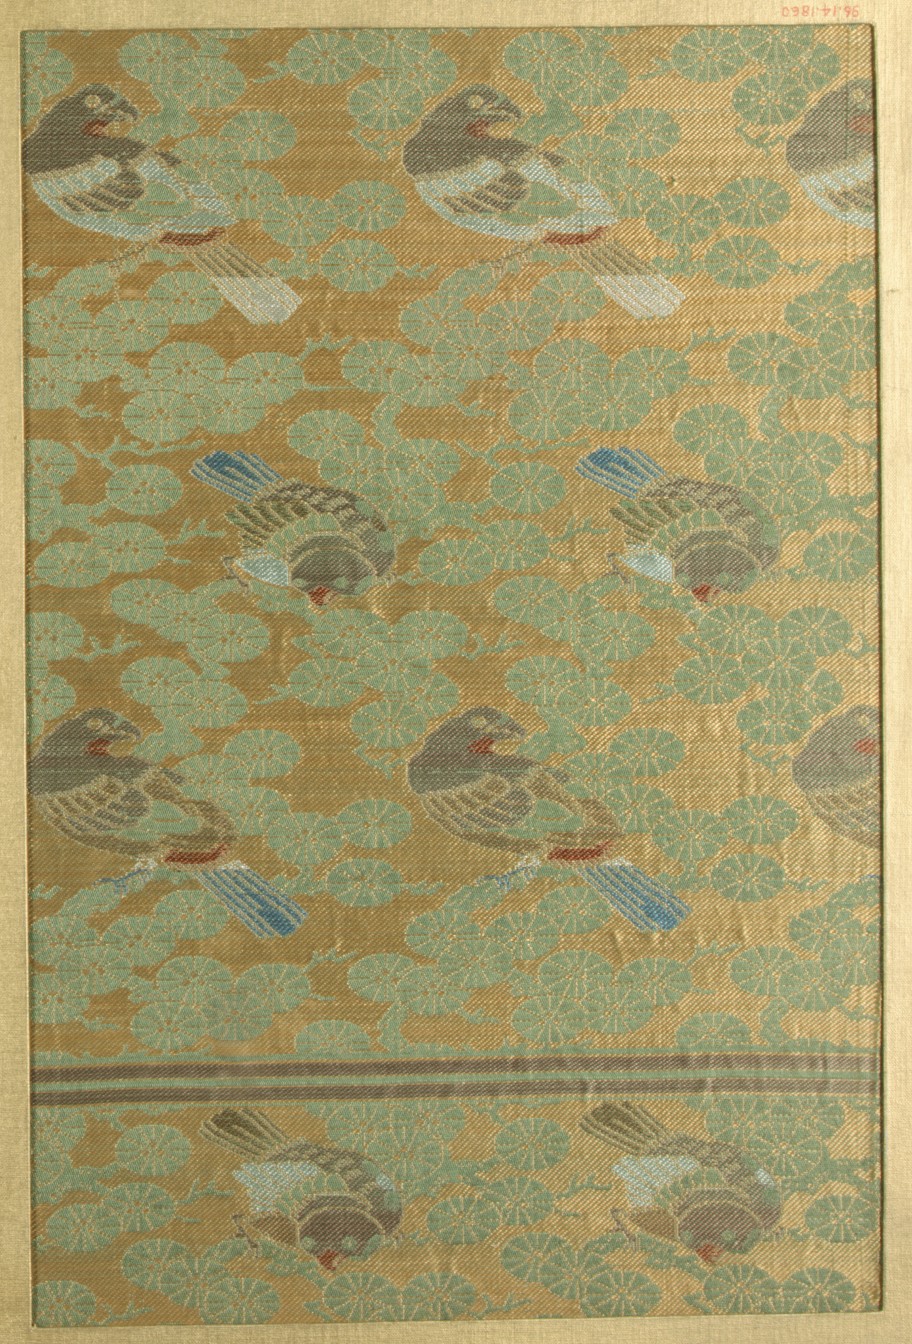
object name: piece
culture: japanese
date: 1701-1900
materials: silk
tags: flowers